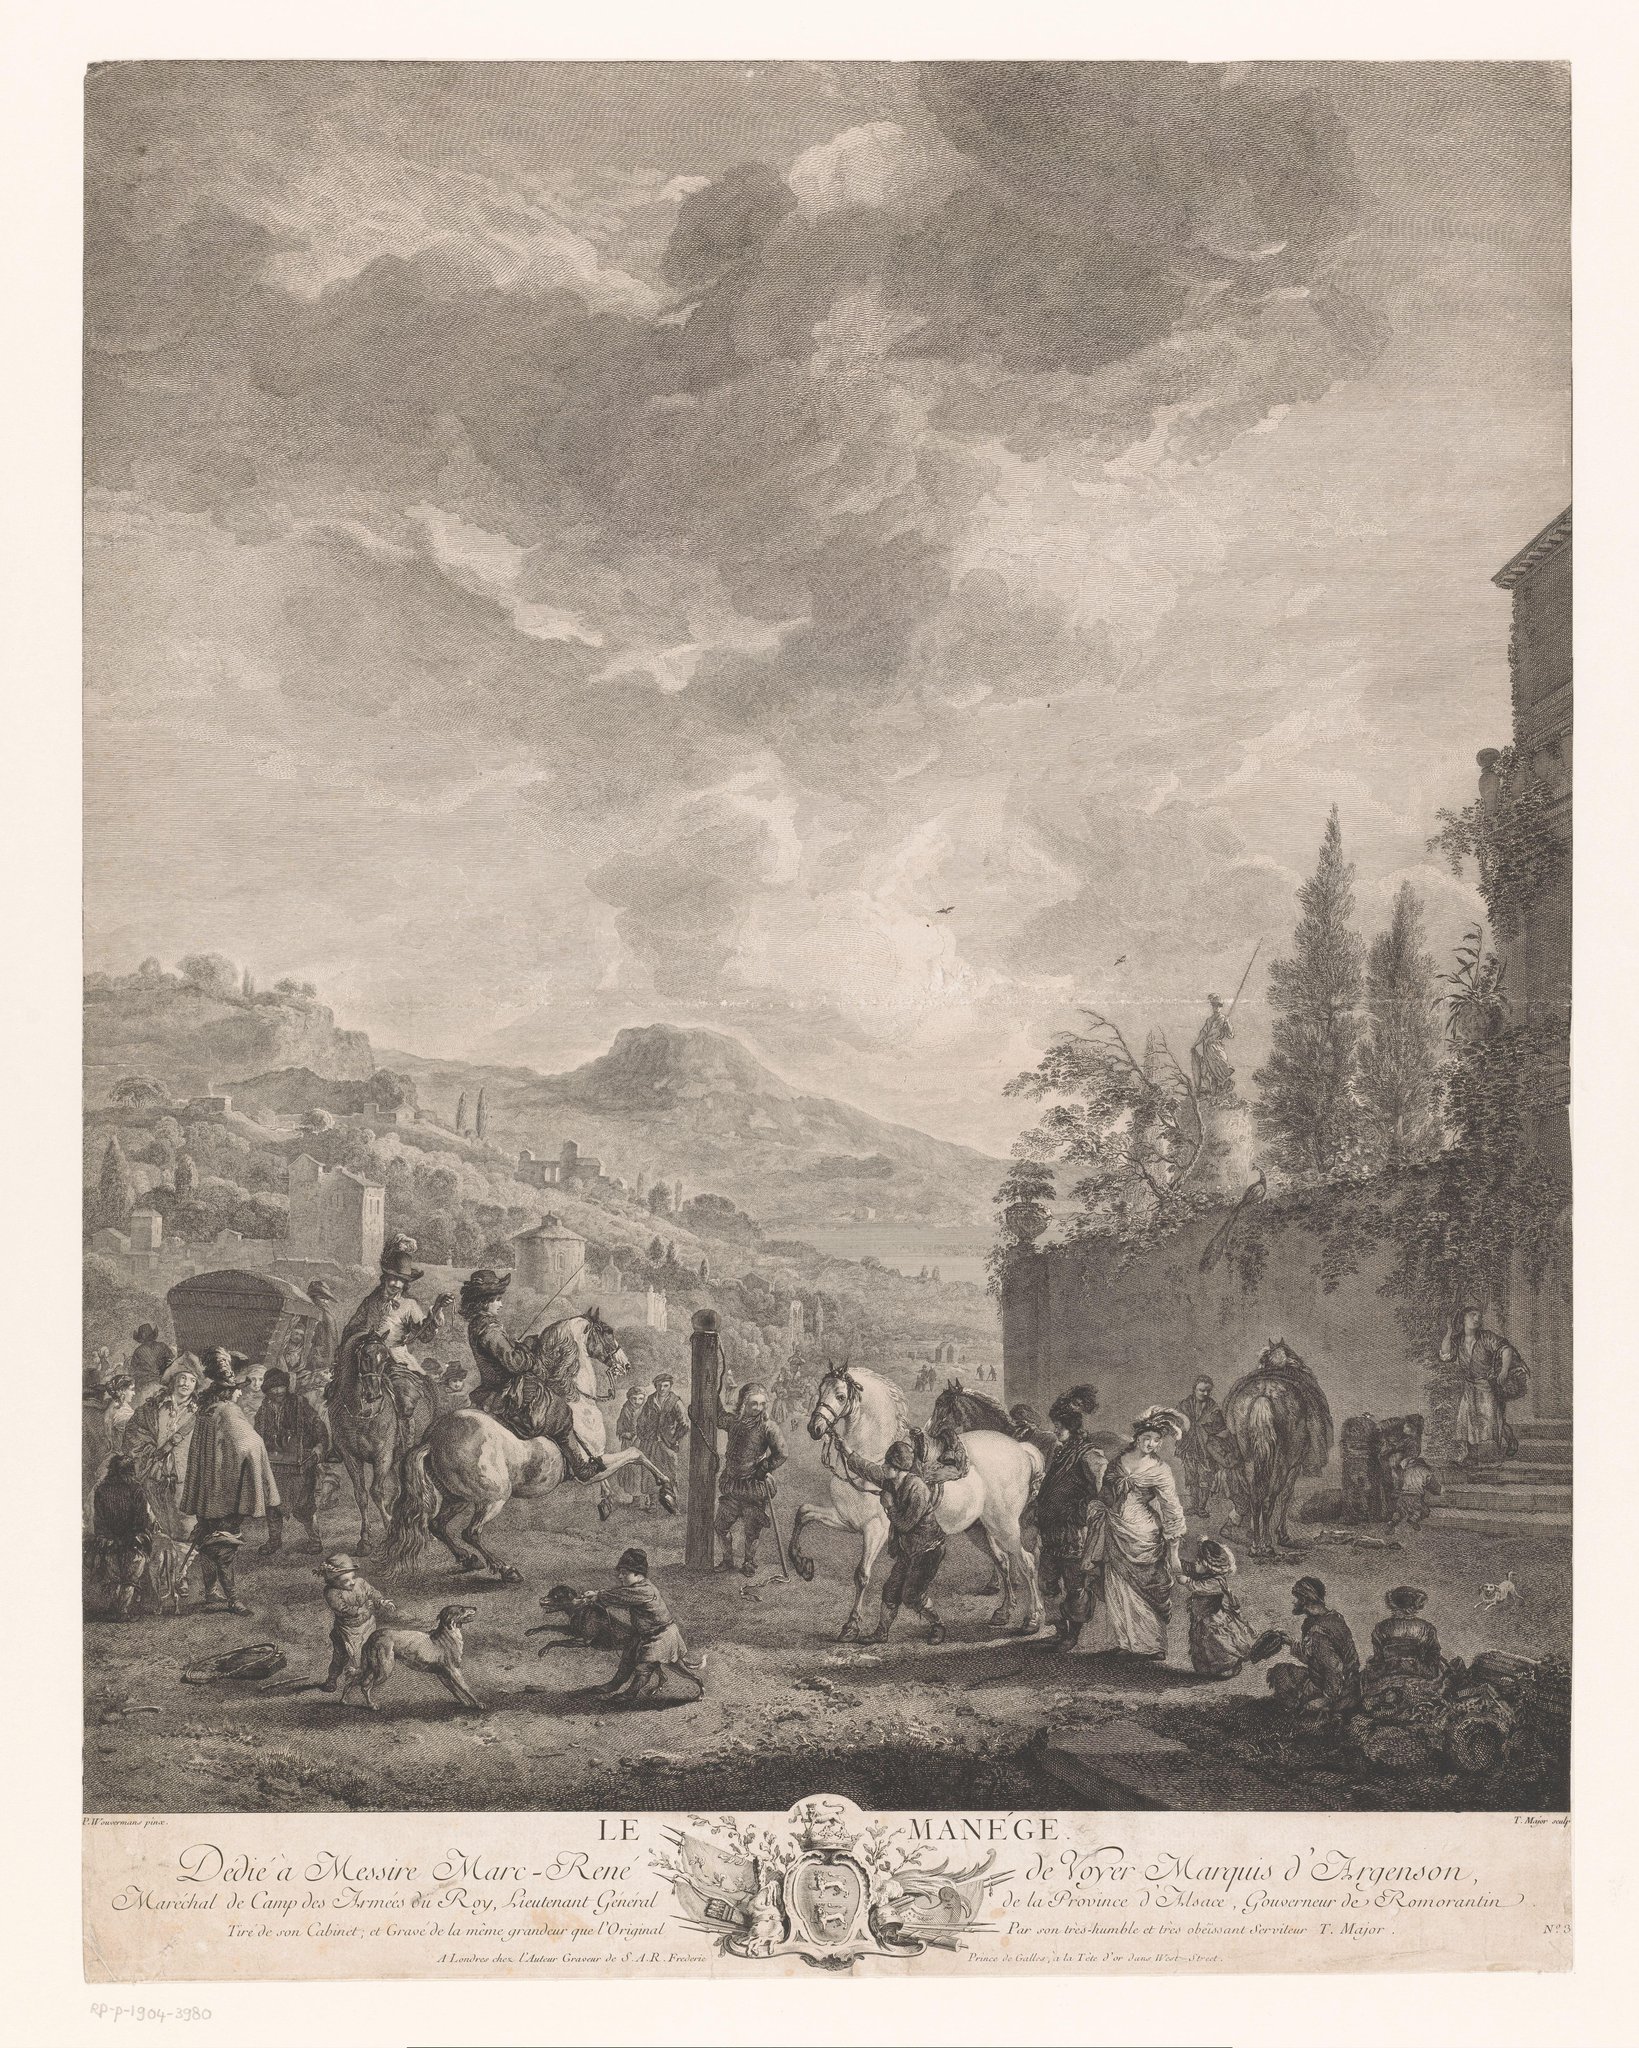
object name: print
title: Heuvellandschap met marktplein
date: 1745-1749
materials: paper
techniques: engraving, etching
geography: paris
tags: low hill country (+ landscape with figures, staffage), horse, market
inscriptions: collector's mark: Lugt 2228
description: Mogelijk onderdeel van een serie 'Musée Français'.